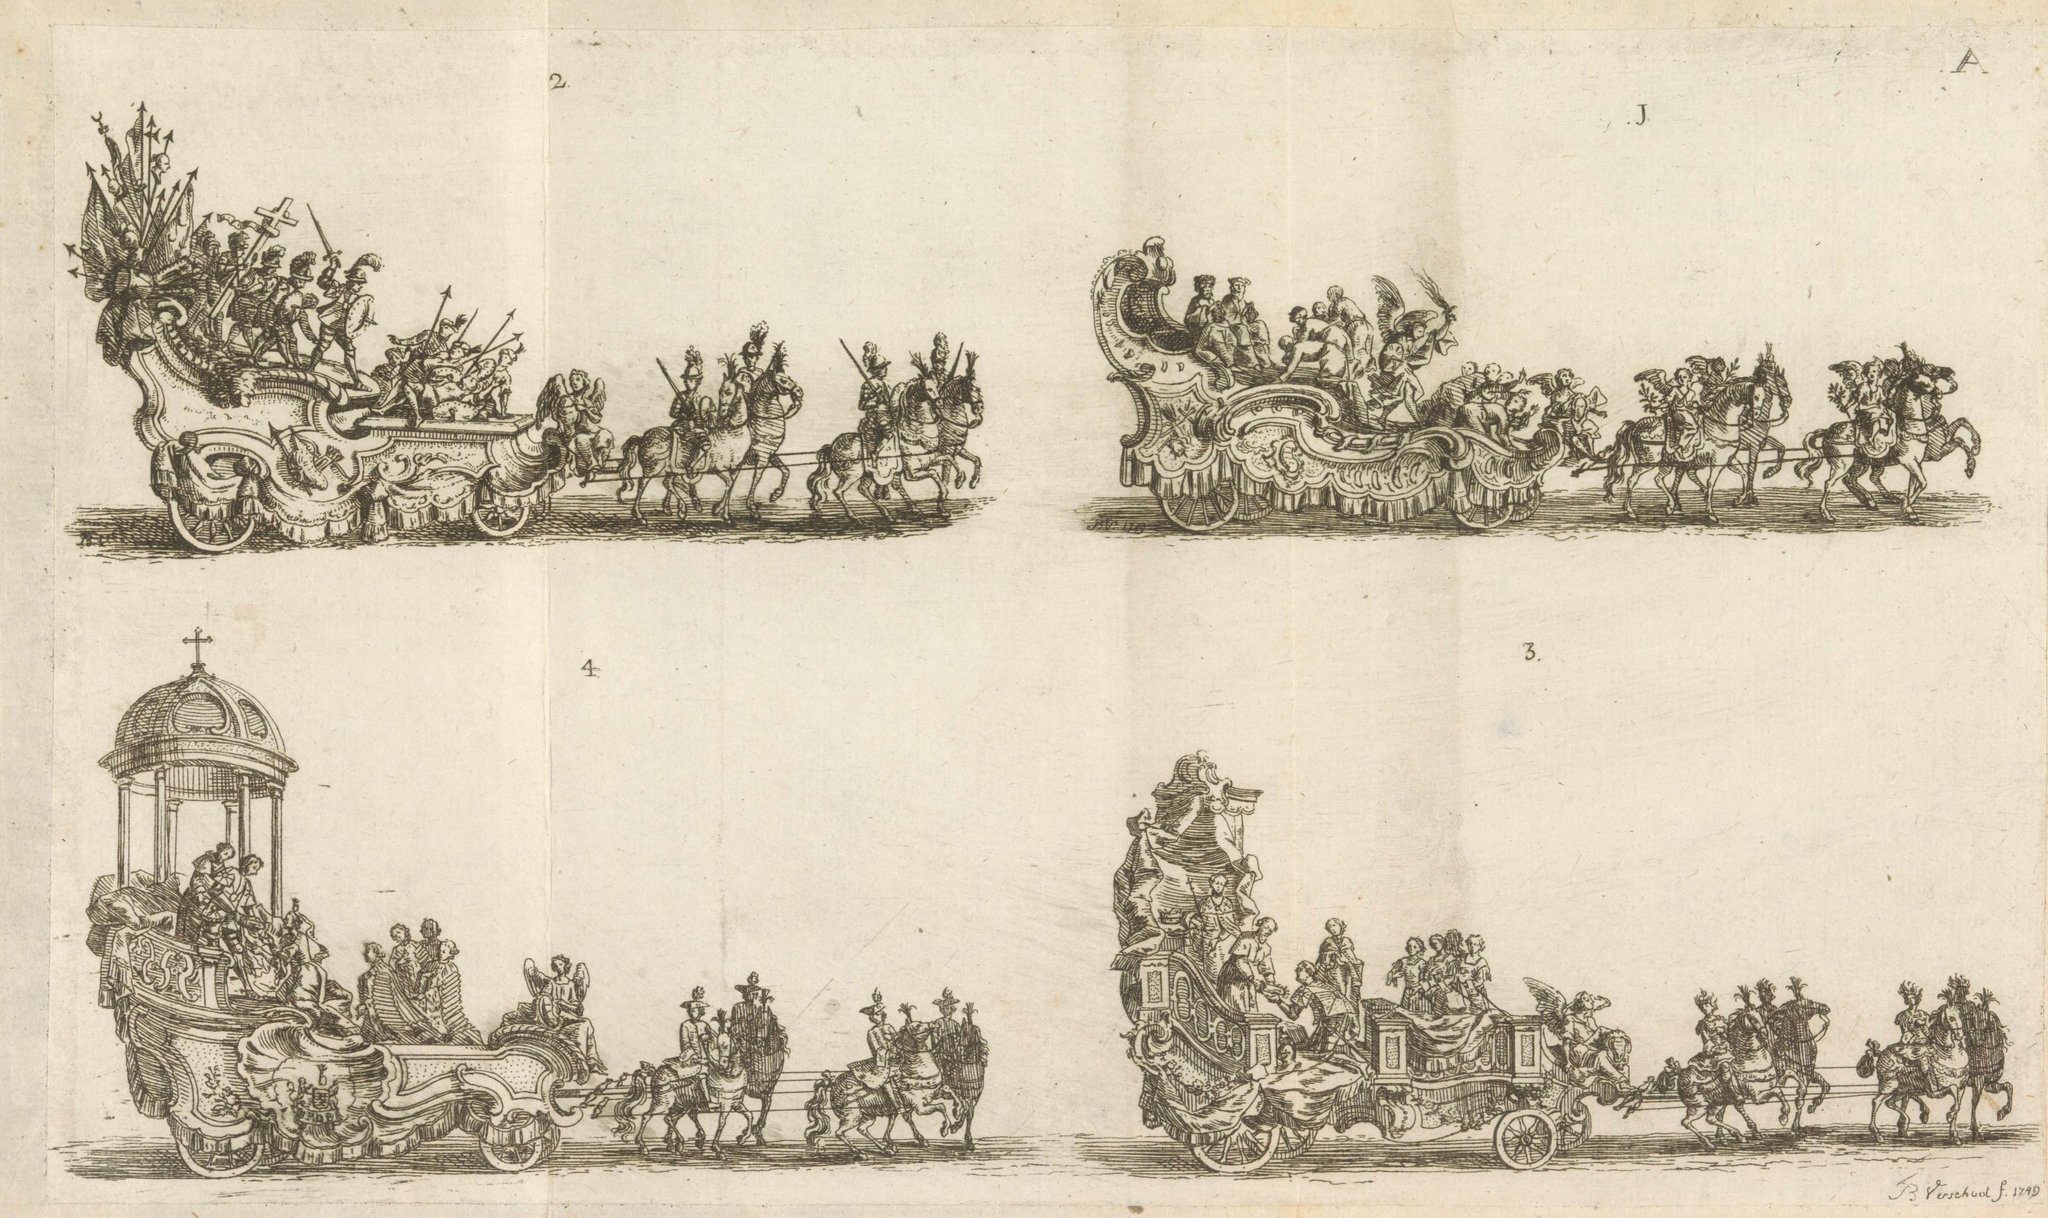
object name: print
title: Vier praalwagens, genummerd 1-4, 1749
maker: bernard verschoot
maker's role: print maker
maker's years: 1728-1783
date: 1749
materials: paper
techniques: etching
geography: southern netherlands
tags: float ~ triumph, bruges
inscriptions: date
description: Vier praalwagens of triomfwagens met allegorische figuren in de optocht bij de viering op 3 mei 1749 van het 600-jarige jubileum van de Heilig-Bloedprocessie in de stad Brugge. Blad A met de wagens genummerd 1-4. Het blad uitgeknipt en opgeplakt.